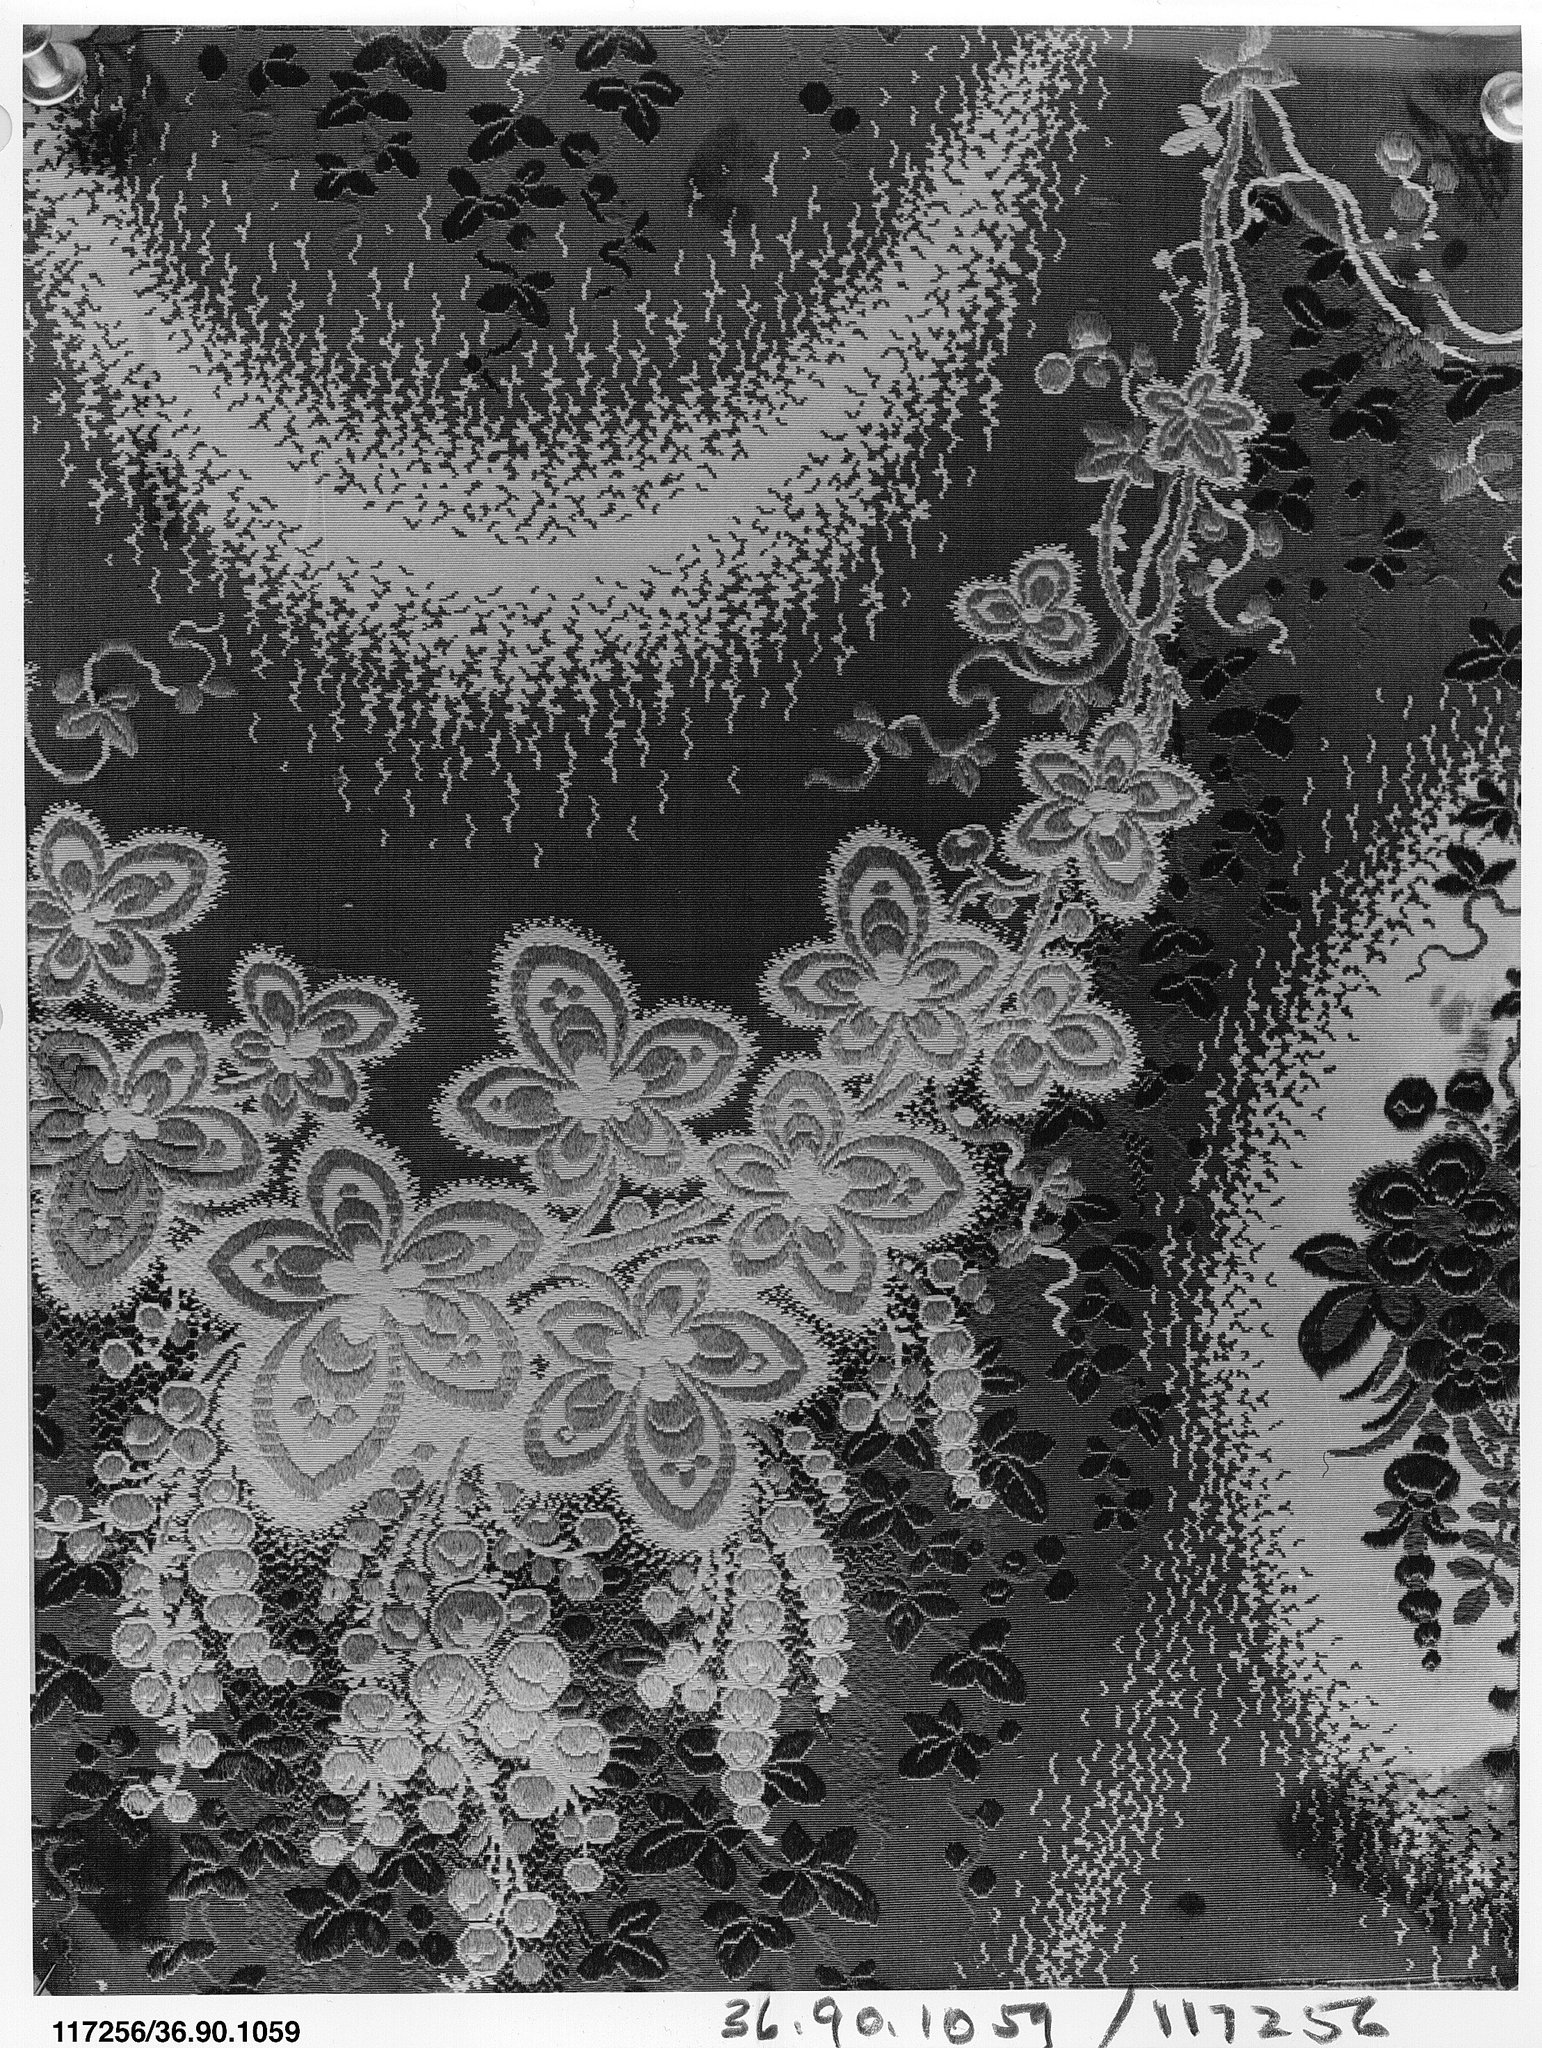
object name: piece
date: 1801-1900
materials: silk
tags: flowers